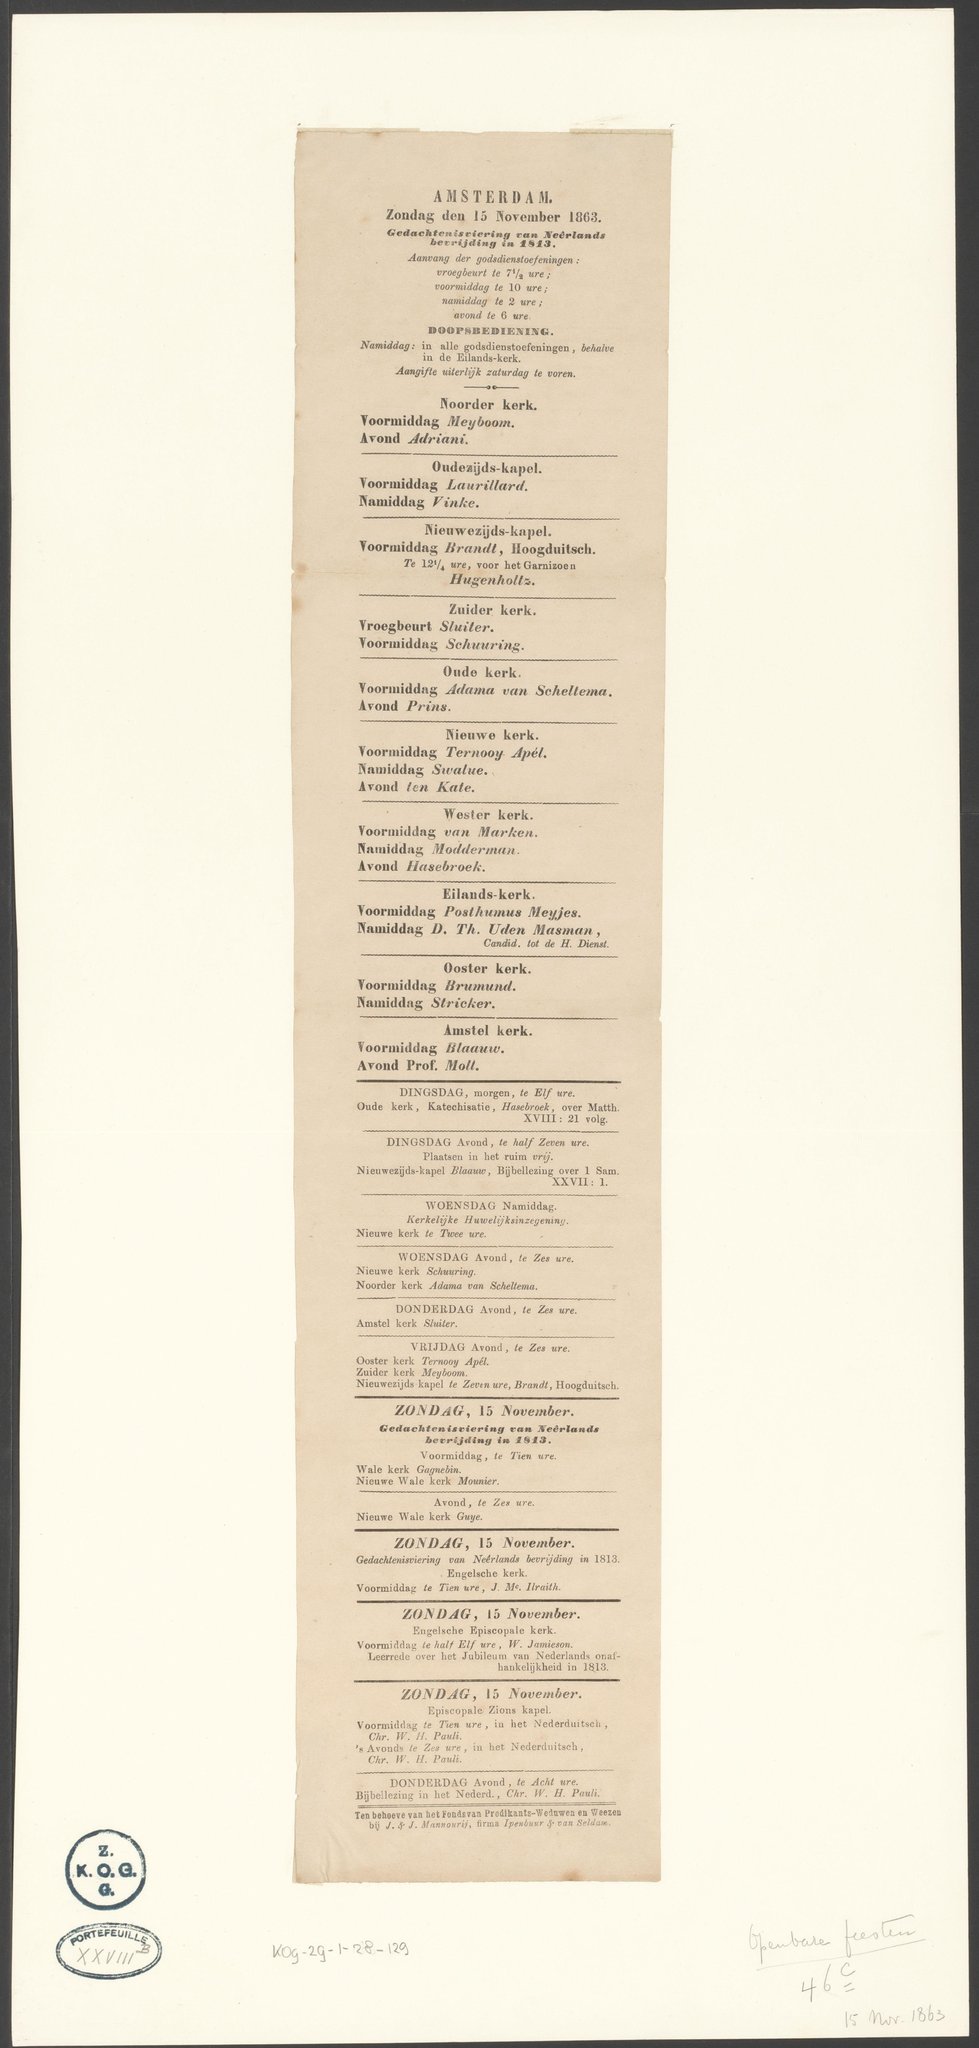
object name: text sheet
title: Overzicht van de herdenking van de bevrijding van Nederland in 1813 in Amsterdamse kerken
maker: Anonymous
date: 1813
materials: paper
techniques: letterpress printing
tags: public festivities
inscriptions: stamp, collector's mark: Lugt 1641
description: Onderwerpsrubrieken binnen de Atlas Zeden en Gewoonten: Zeden en Gewoonten in Engeren Zin. Volksleven. Openbare feesten. Vorstelijke intochten, (Illuminaties, vuurwerken en dergelijke, openbare feesten).